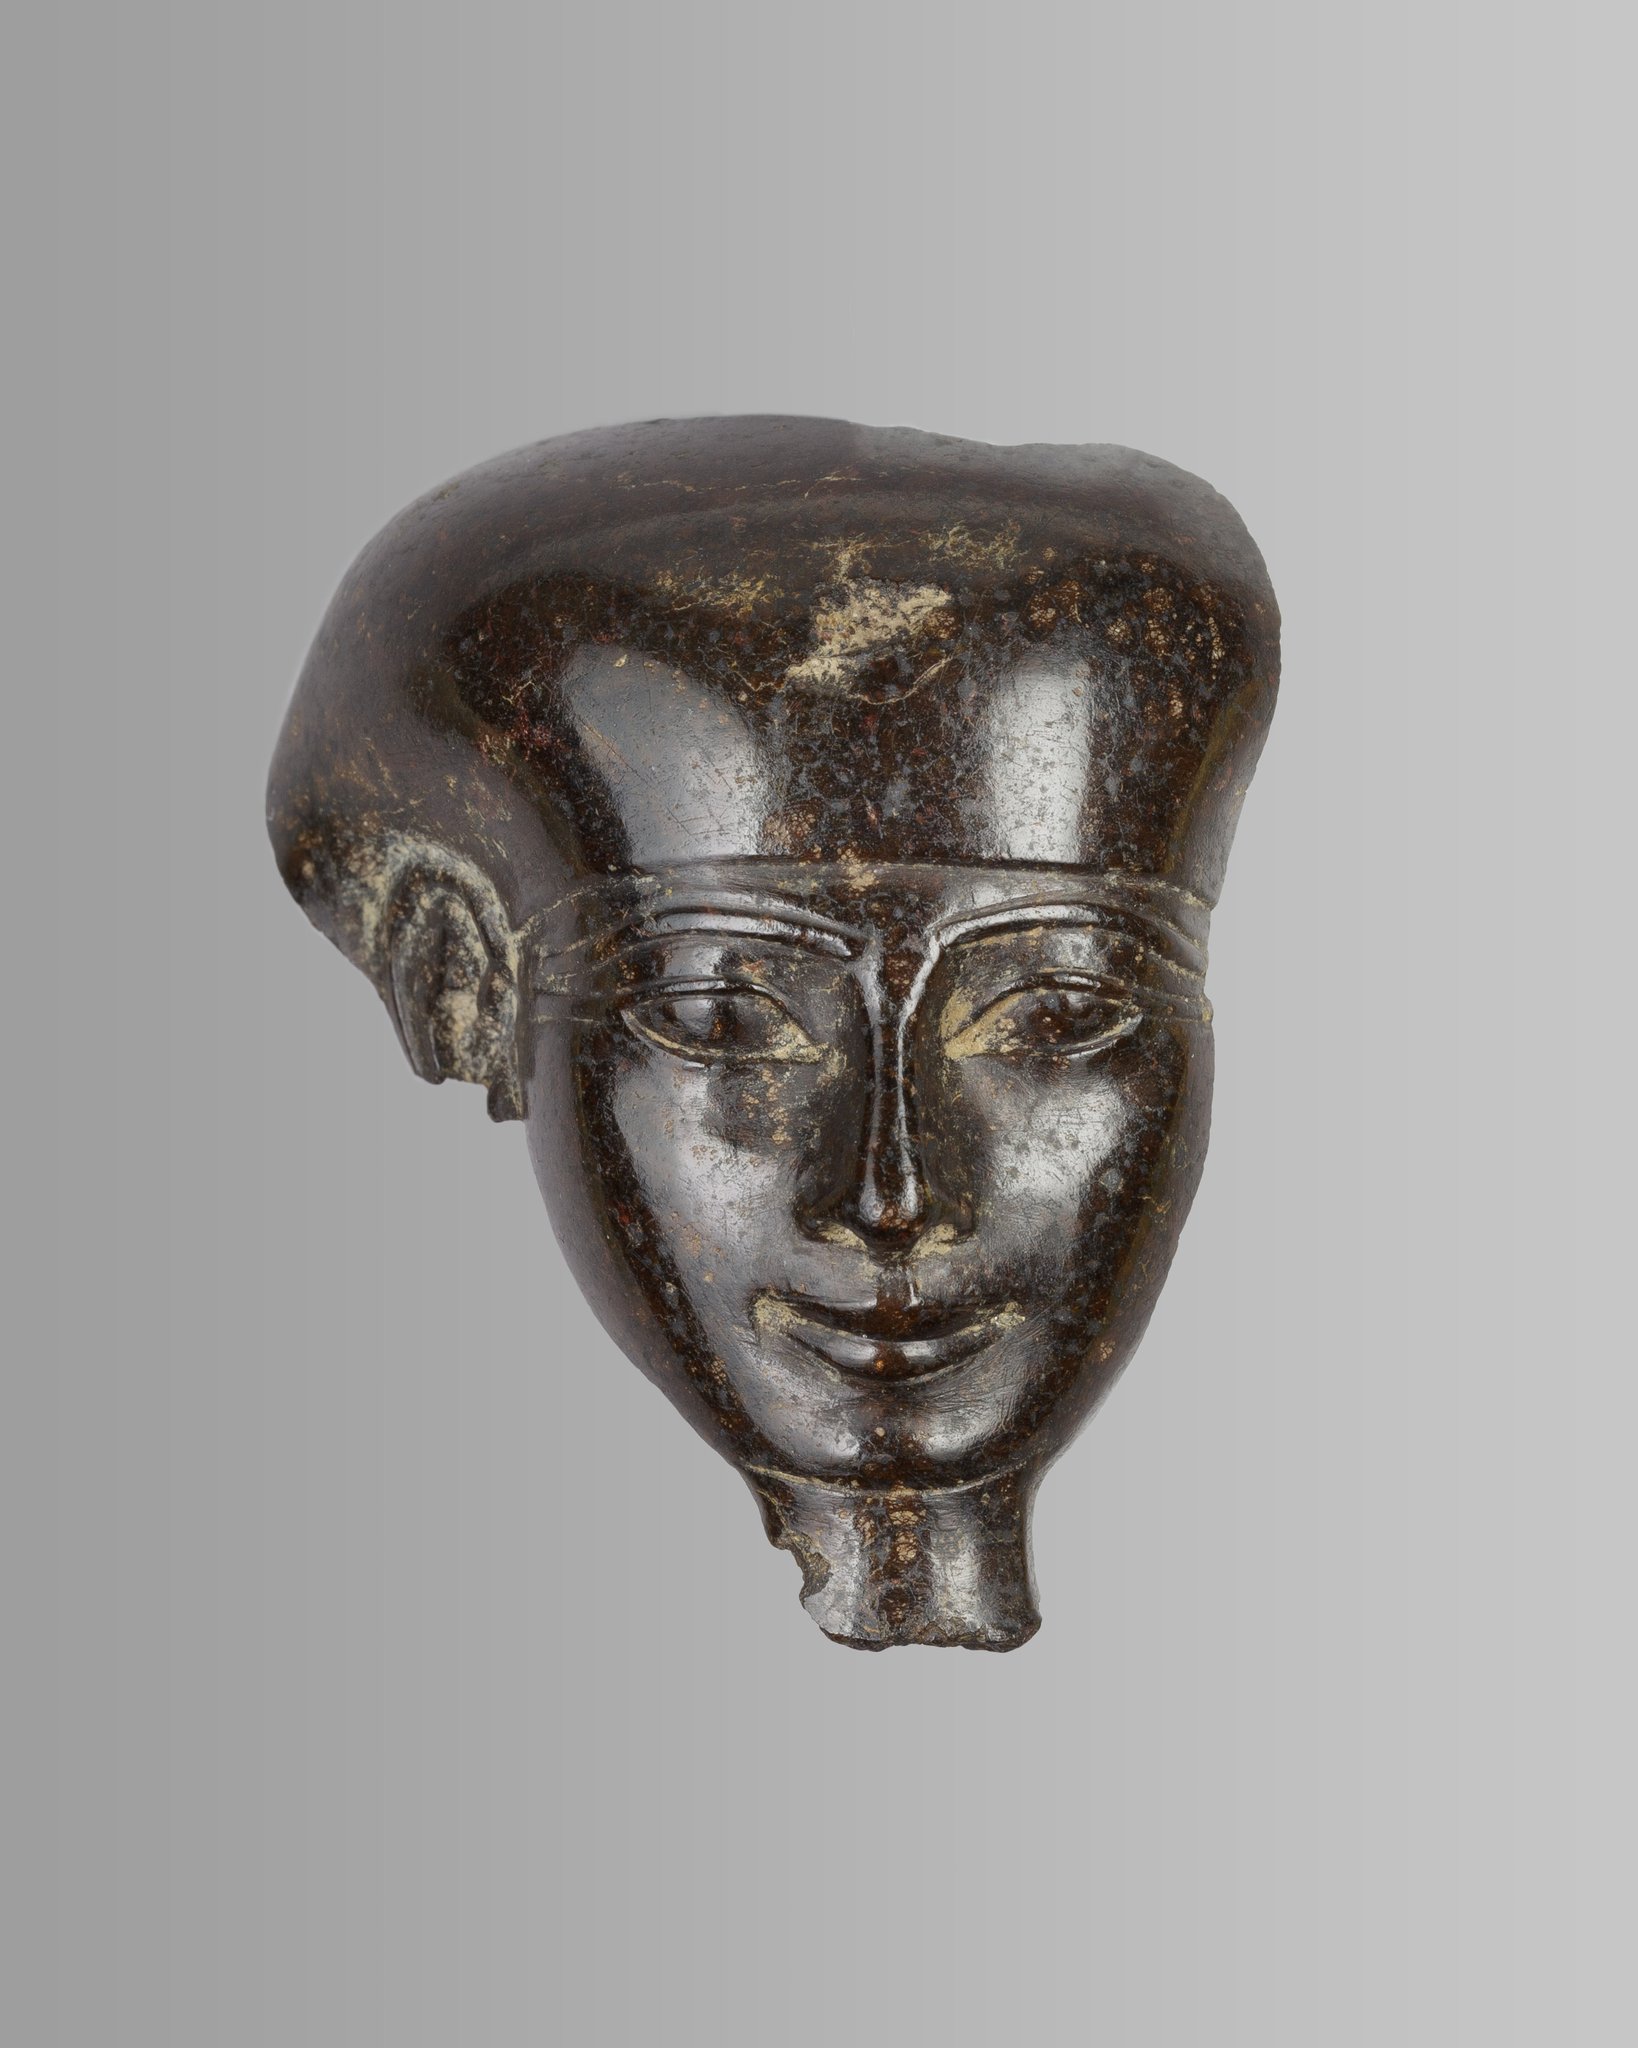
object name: shabti, head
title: Head with tripartite wig, probably from a shabti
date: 1450-1400 BCE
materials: stone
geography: egypt